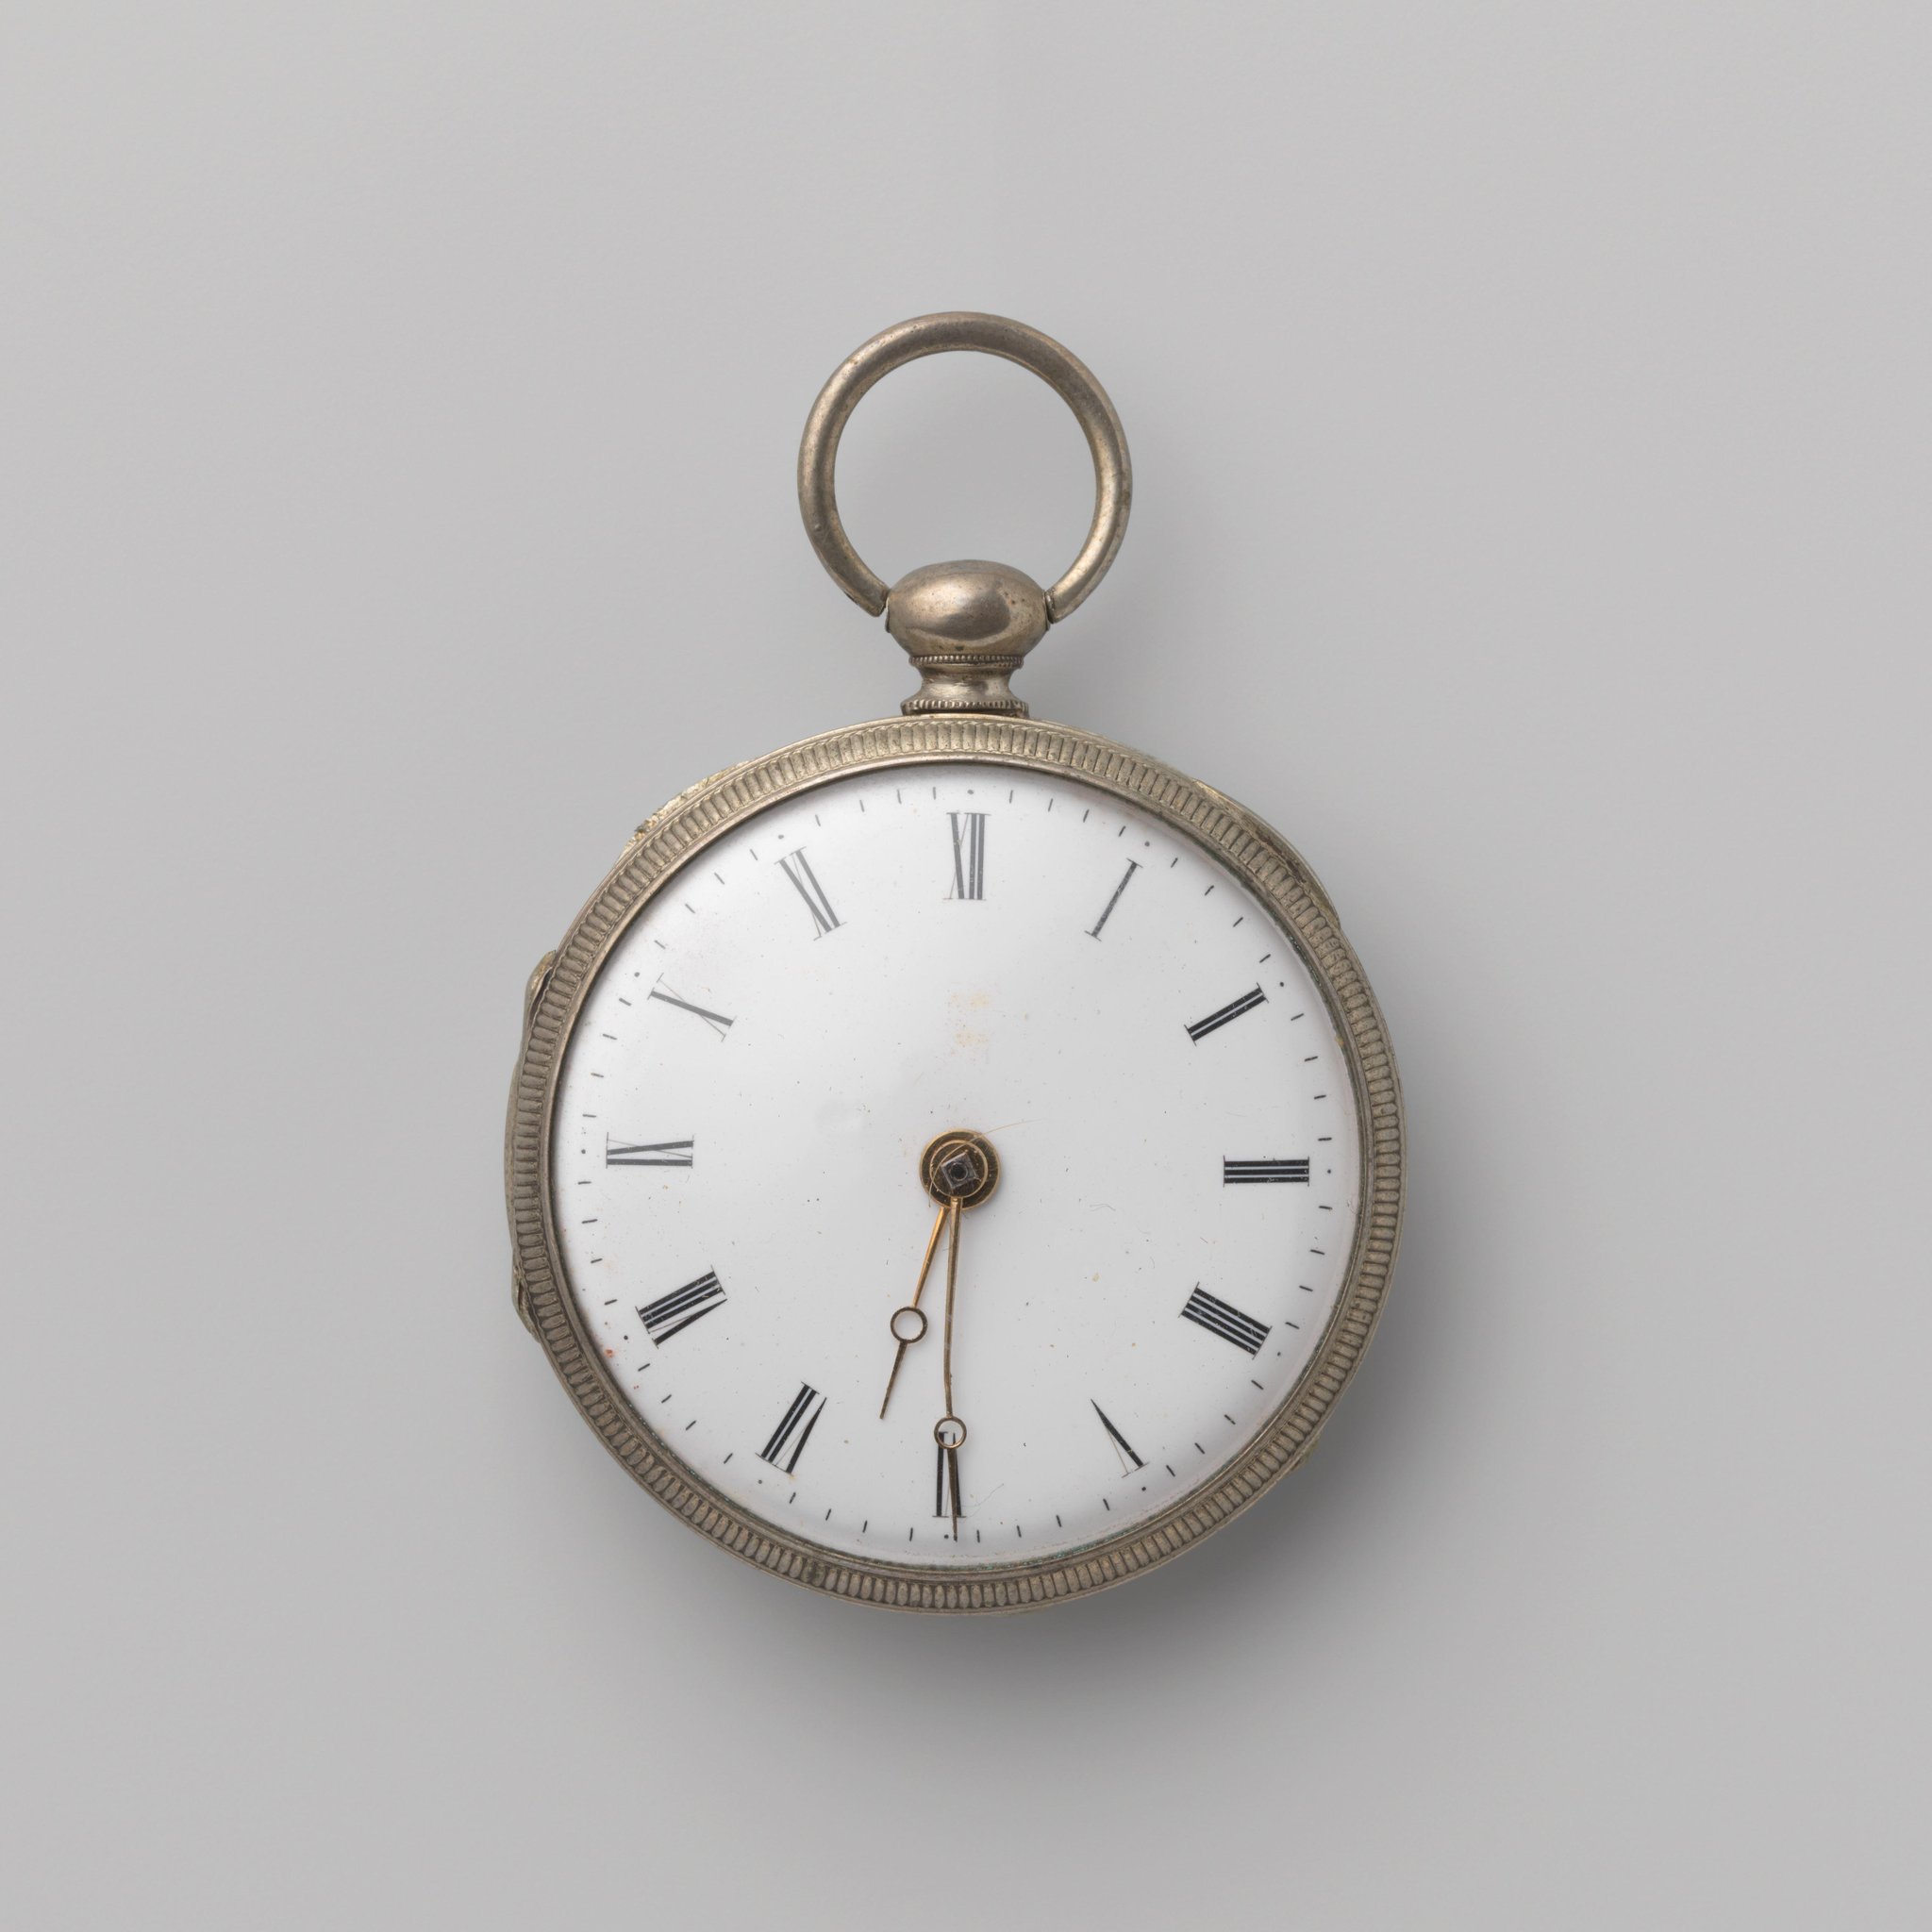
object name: wrist watch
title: Horloge van zilver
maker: Anonymous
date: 1865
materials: silver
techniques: engine turning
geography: france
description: Horloge van zilver, met spillegang en witgeëmailleerde wijzerplaat. De achterbodem is geguillocheerd met uitzondering van een medaillon met ranken en bladornament.